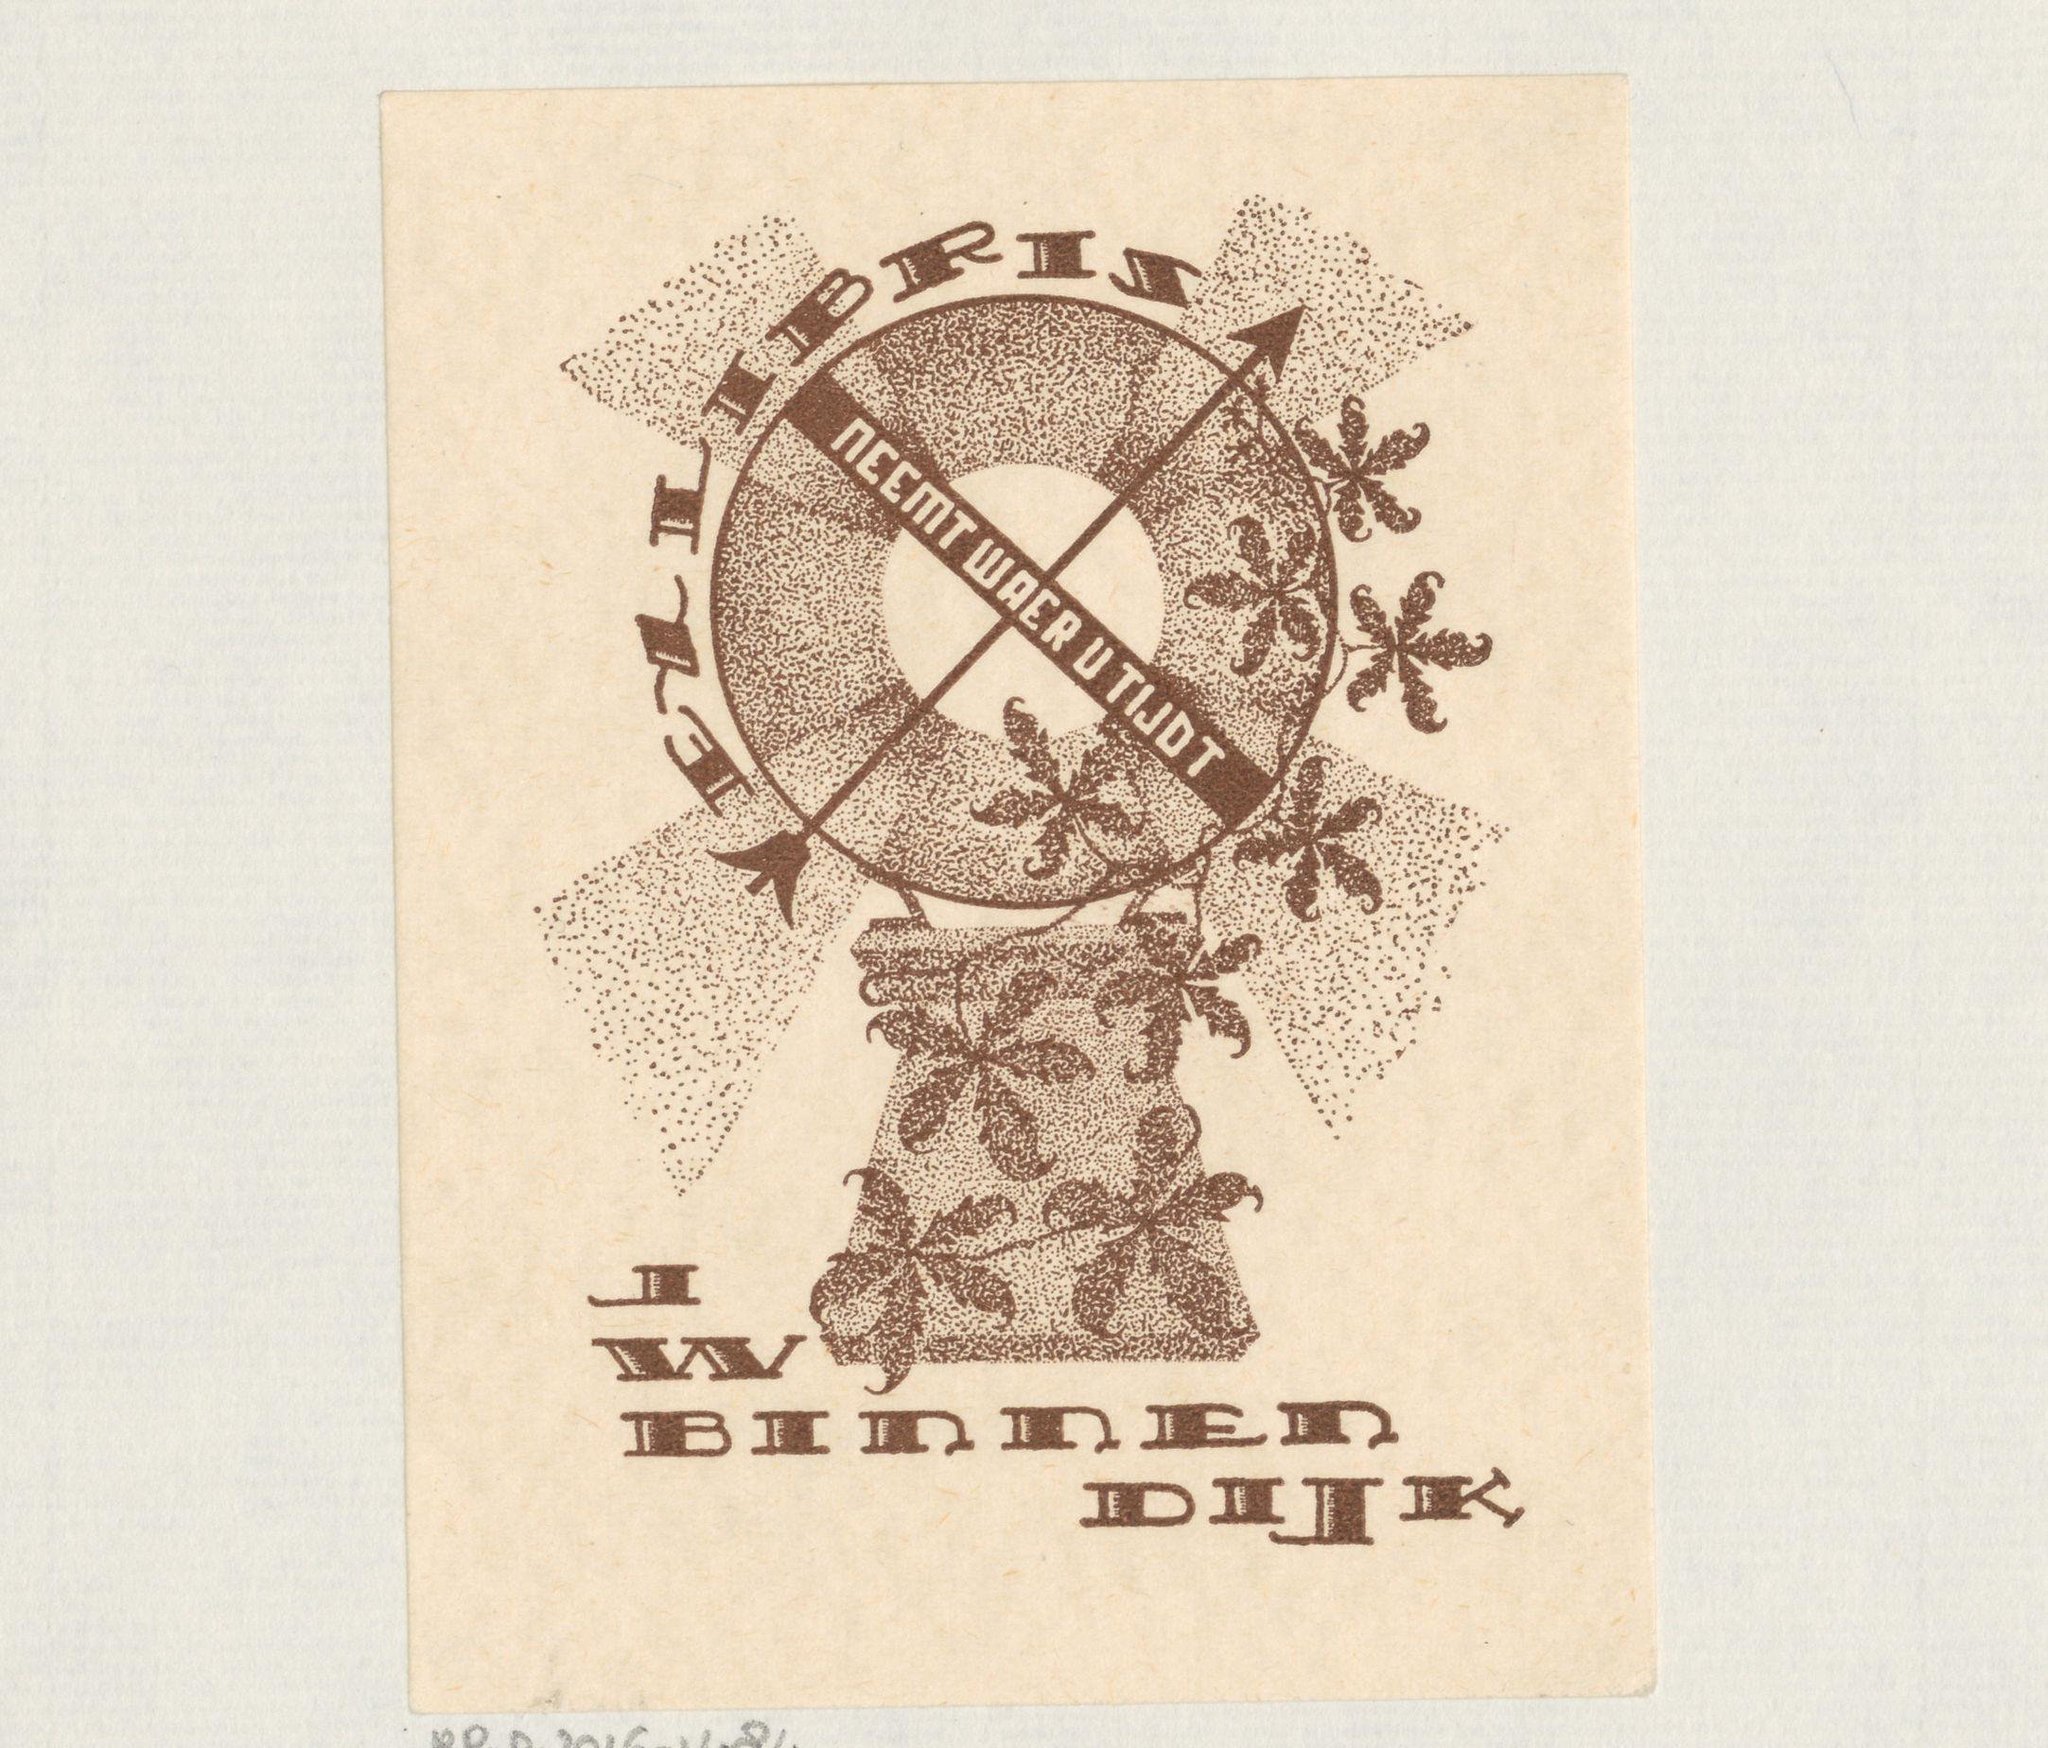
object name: bookplate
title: Ex libris van J.W. Binnendijk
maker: j.w. binnendijk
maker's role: print maker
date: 1941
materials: paper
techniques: printing block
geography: netherlands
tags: print maker, j.w. binnendijk, sundial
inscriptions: signature, date and inscription: ‘ipse fecit 1941 / 31’